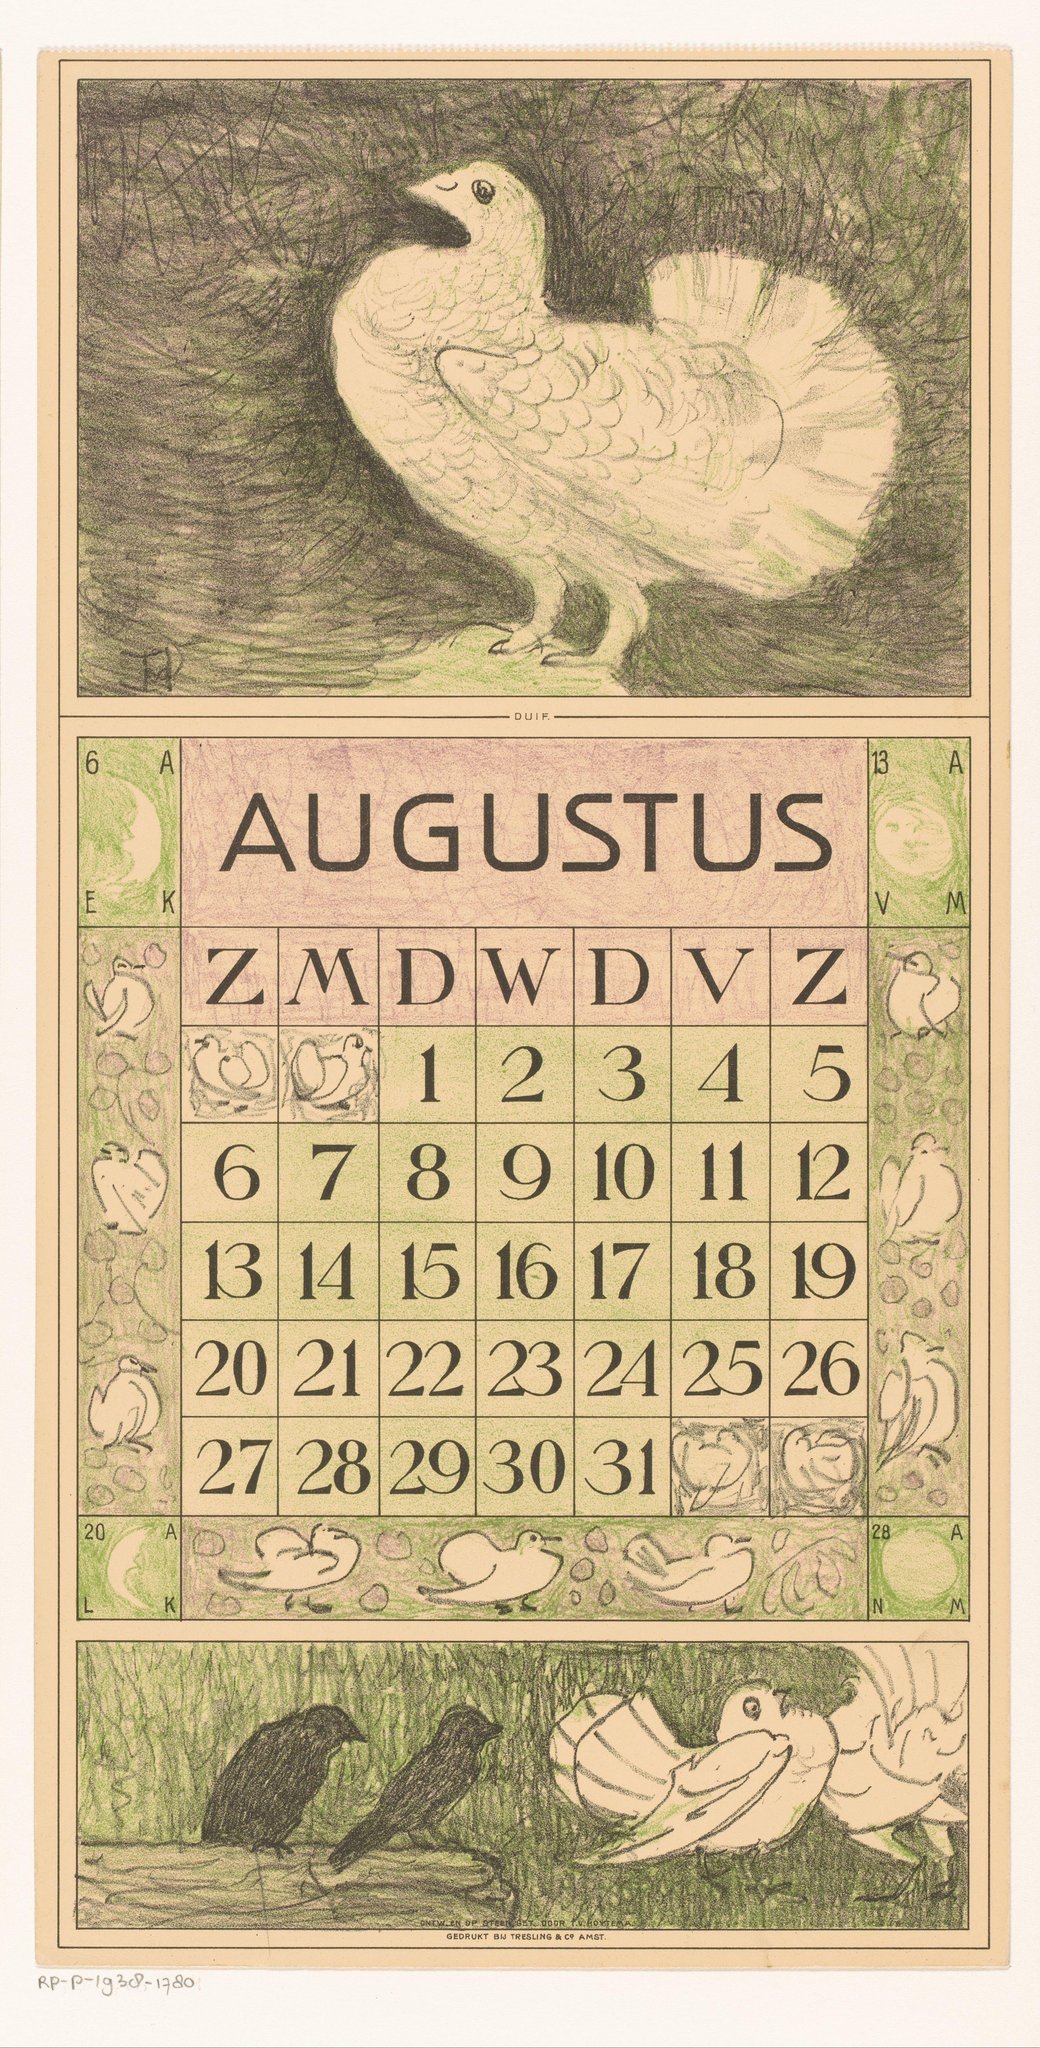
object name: print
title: Kalender 1916 12 lithografien door Th. v. Hoytema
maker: theo van hoytema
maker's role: draughtsman, painter, print maker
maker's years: 1863-1917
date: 1915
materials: paper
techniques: lithograph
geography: amsterdam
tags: lunar year, august ~ other concepts, doves, pigeons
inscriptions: collector's mark: Lugt 2228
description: In de ornamentrand duiven. Onderin twee duiven en twee zwarte vogels. In de hoeken de standen van de maan op vier dagen. Bovenaan het blad een scheurlijn.